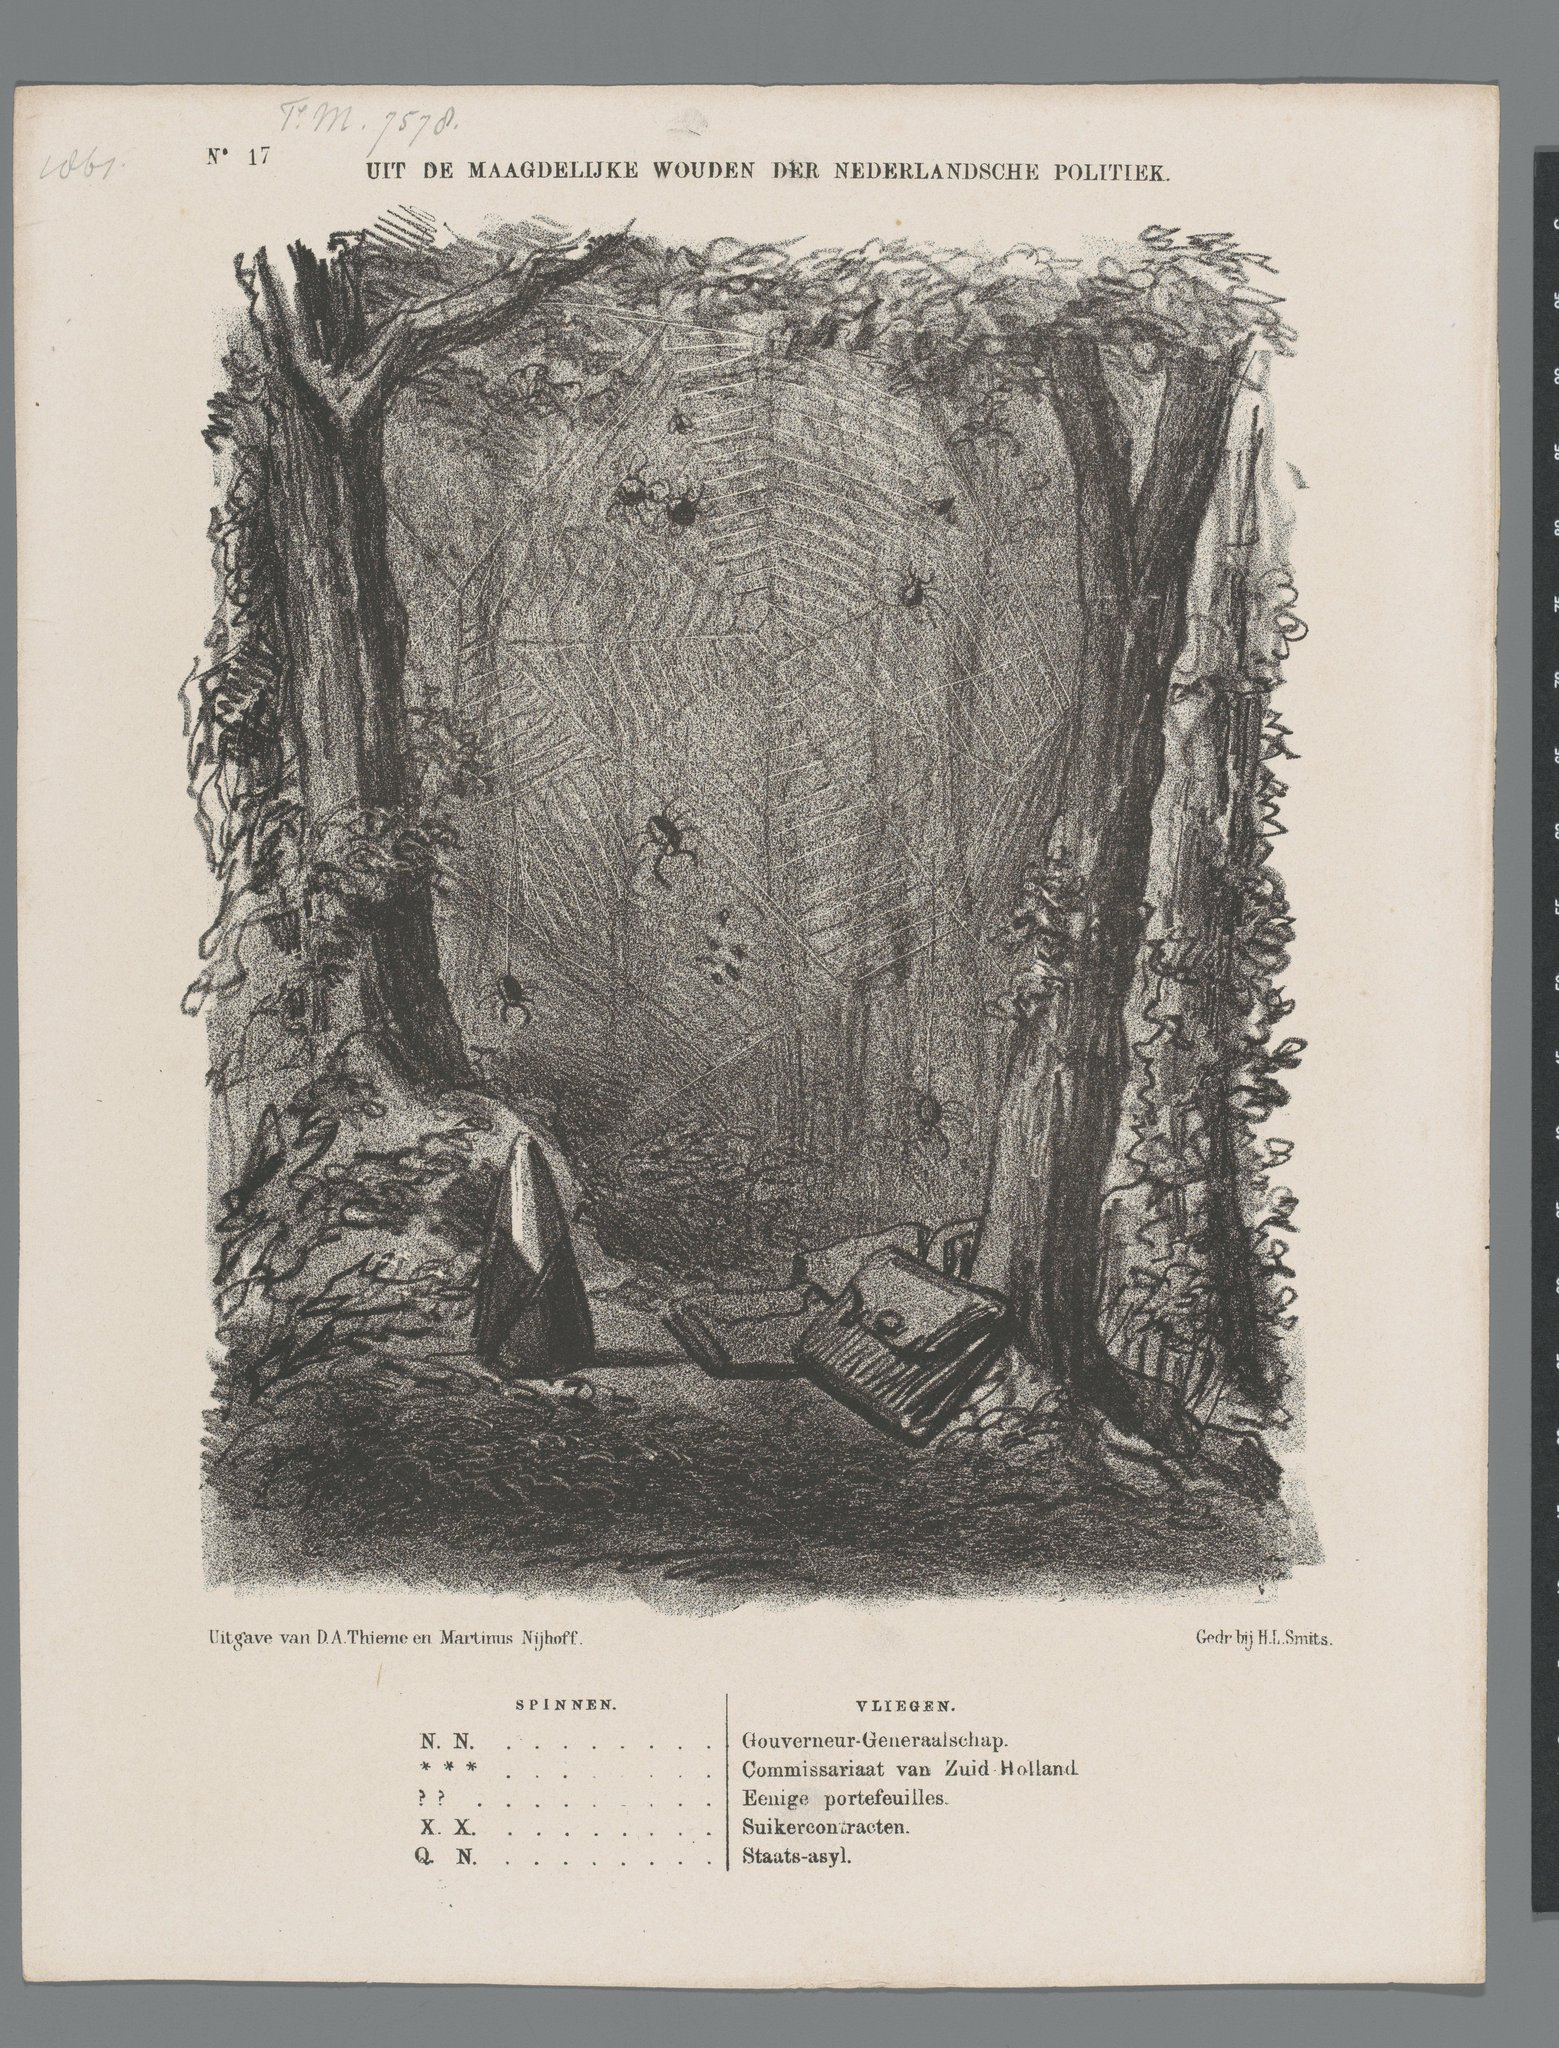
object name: print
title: Uit de maagdelijke wouden der Nederlandsche politiek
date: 1861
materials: paper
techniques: lithograph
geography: arnhem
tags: forest, wood, spiders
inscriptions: collector's mark: Lugt 2228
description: Spotprent op de Nederlandse politiek. Donker bos waarin een groot spinnenweb. Op de grond een suikerbrood en enkele ministeriële portefeuilles. Plaat verschenen bij het weekblad De Nederlandsche Spectator, nr. 17, 27 april 1861.